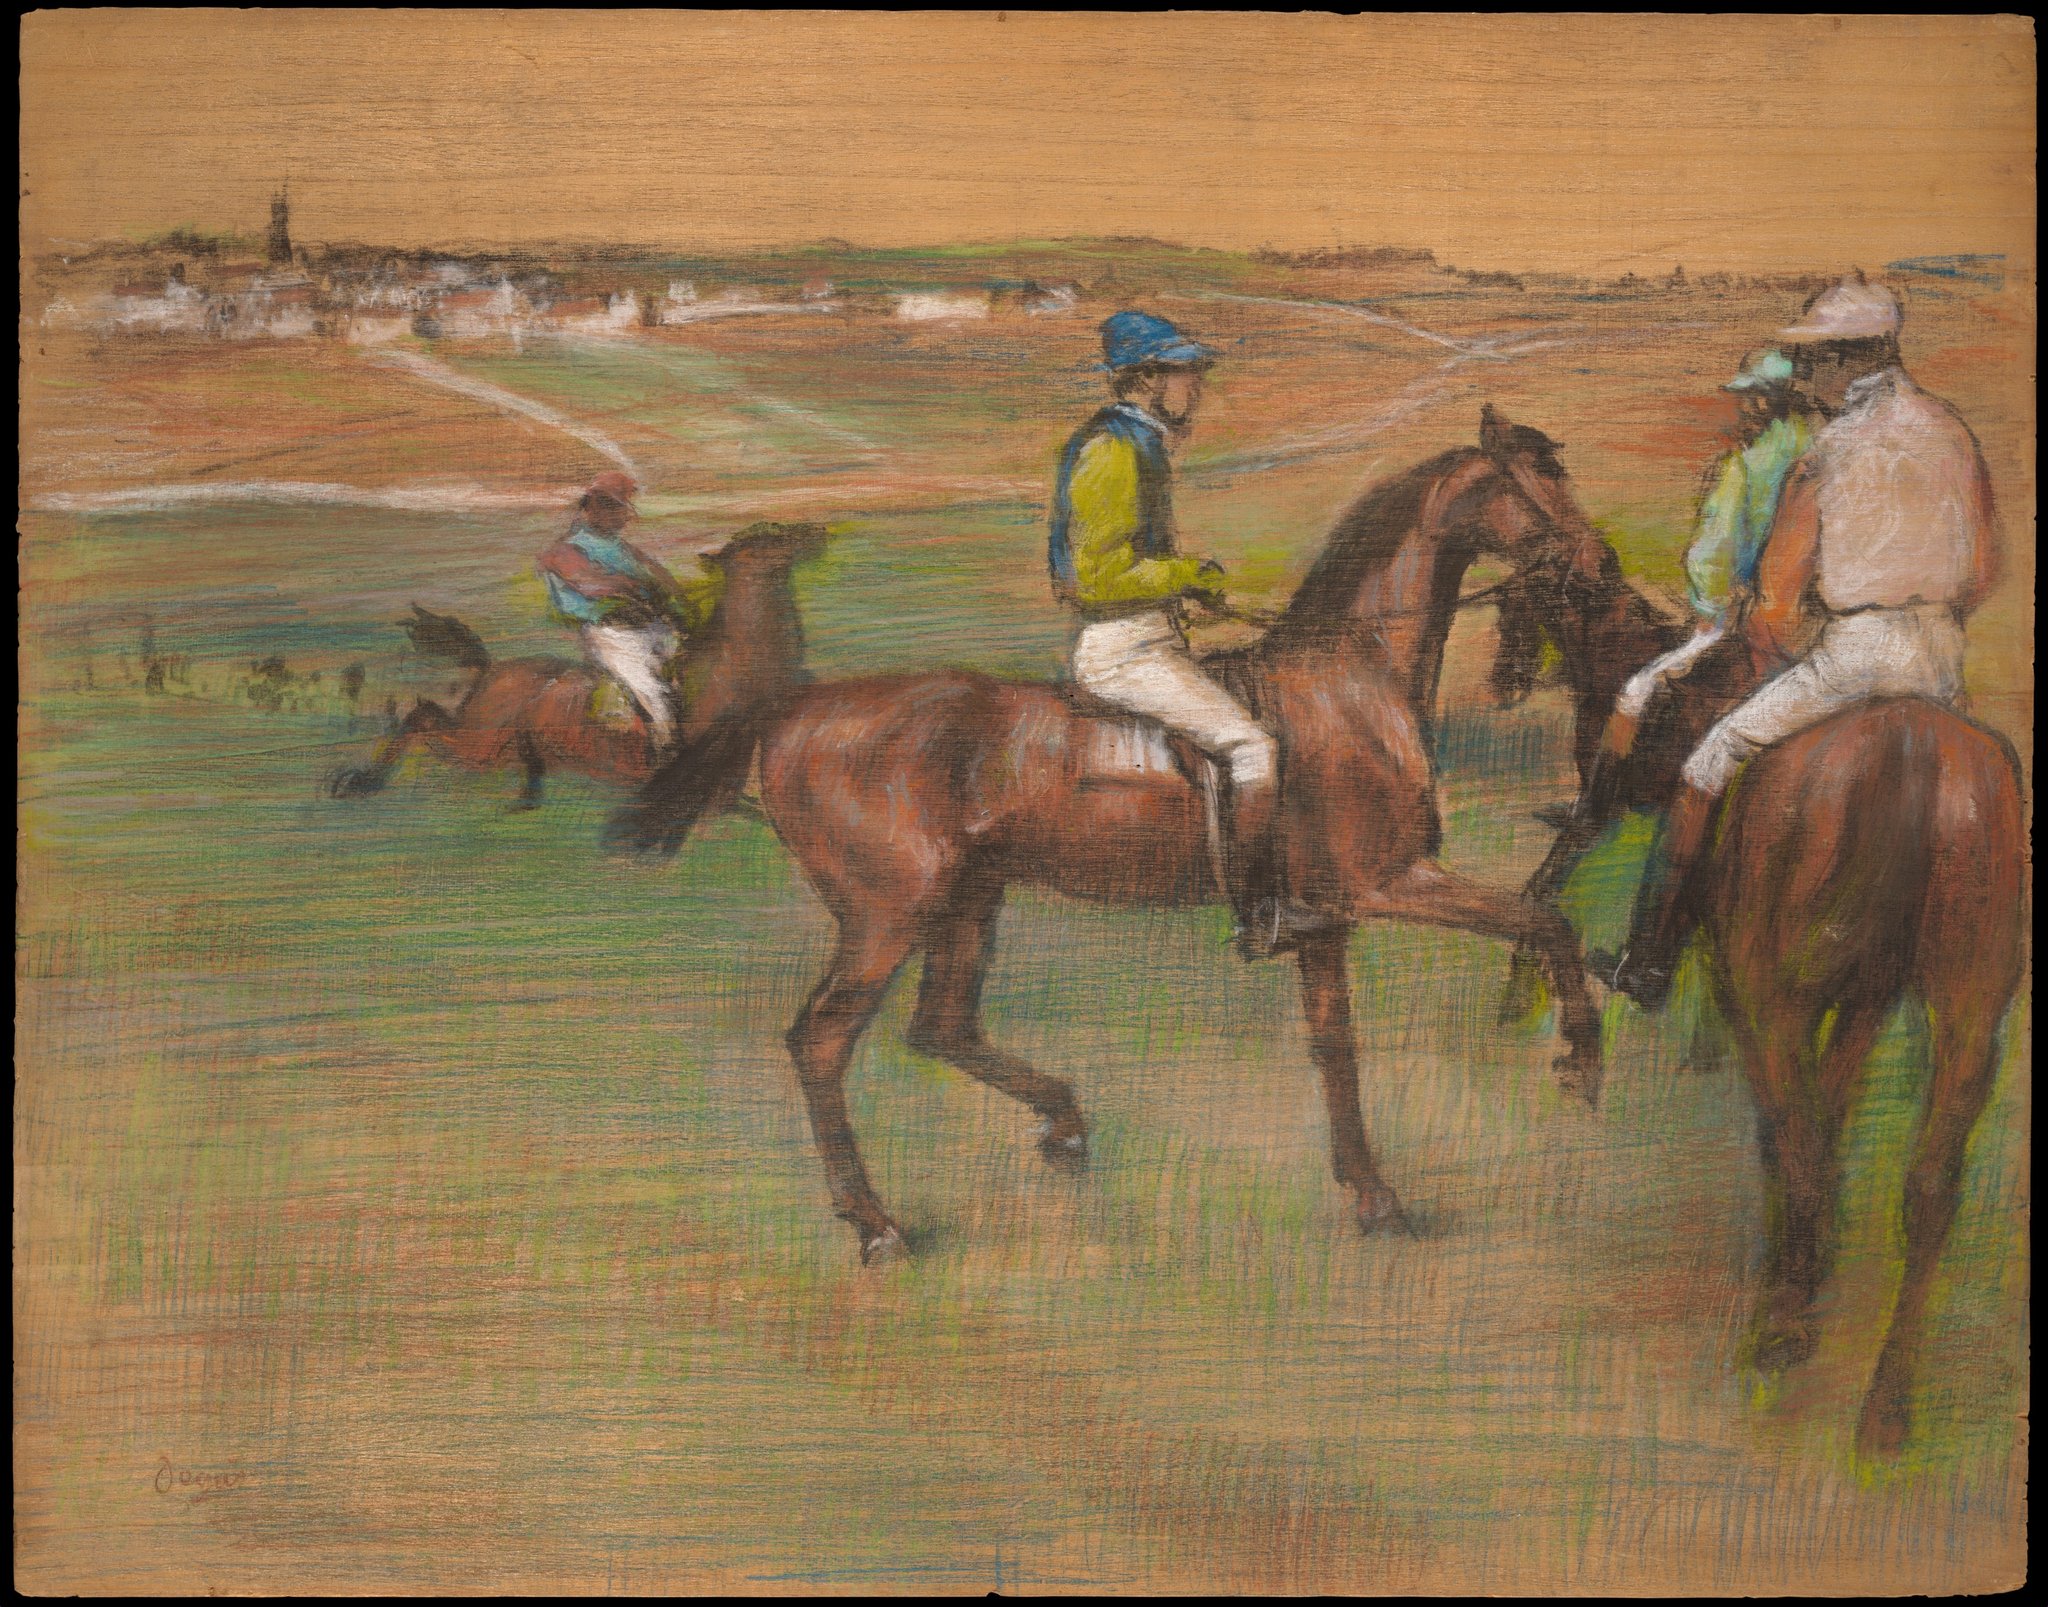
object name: drawing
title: Race Horses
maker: edgar degas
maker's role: artist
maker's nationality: french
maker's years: 1834-1917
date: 1885-1888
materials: pastel, wood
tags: men,horses,jockeys